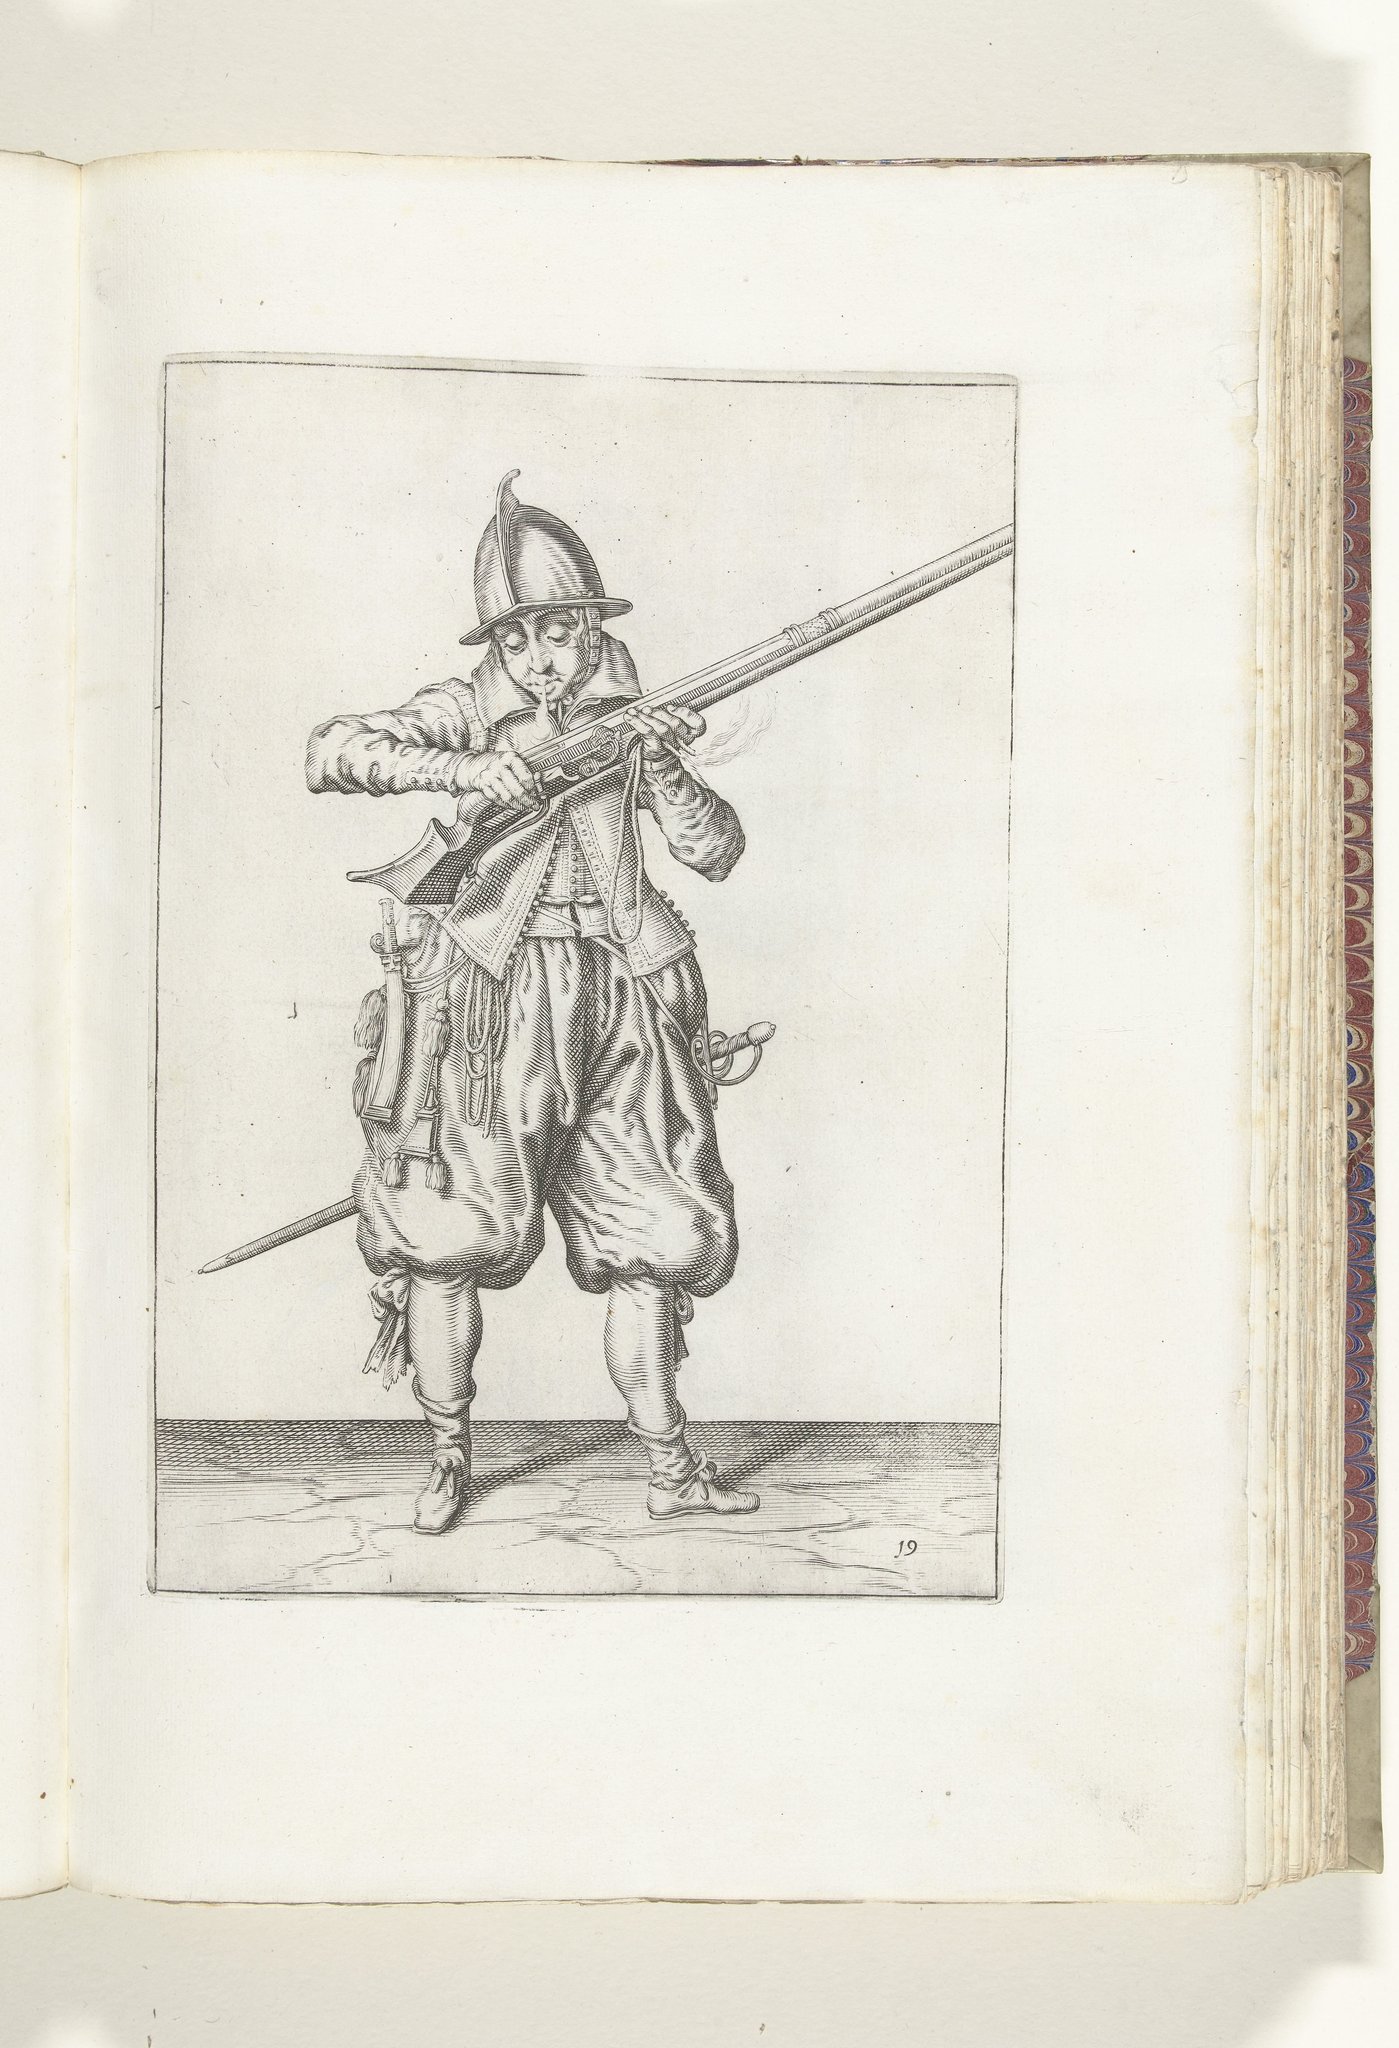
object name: print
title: Soldaat die kruit van zijn roer blaast (nr. 19), ca. 1600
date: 1597-1607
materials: paper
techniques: engraving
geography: amsterdam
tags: the hague, maurice (prince of orange), handling of weapons ~ military training, weapons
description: Een soldaat, ten voeten uit, die met beide handen een roer (een bepaald type vuurwapen) bij zijn mond houdt en erover blaast, om eventueel buiten de pan (het kruitreservoir) gevallen kruit ervan af te krijgen (nr. 19), ca. 1600. In zijn linkerhand behalve de loop van het roer ook een brandende lont. Plaat 19 in de instructies voor het hanteren van de roer. Onderdeel van de illustraties in: J. de Gheyn, Wapenhandelinghe van Roers Musquetten ende spiessen, Amsterdam, 1608. Krijgswezen rond 1600.